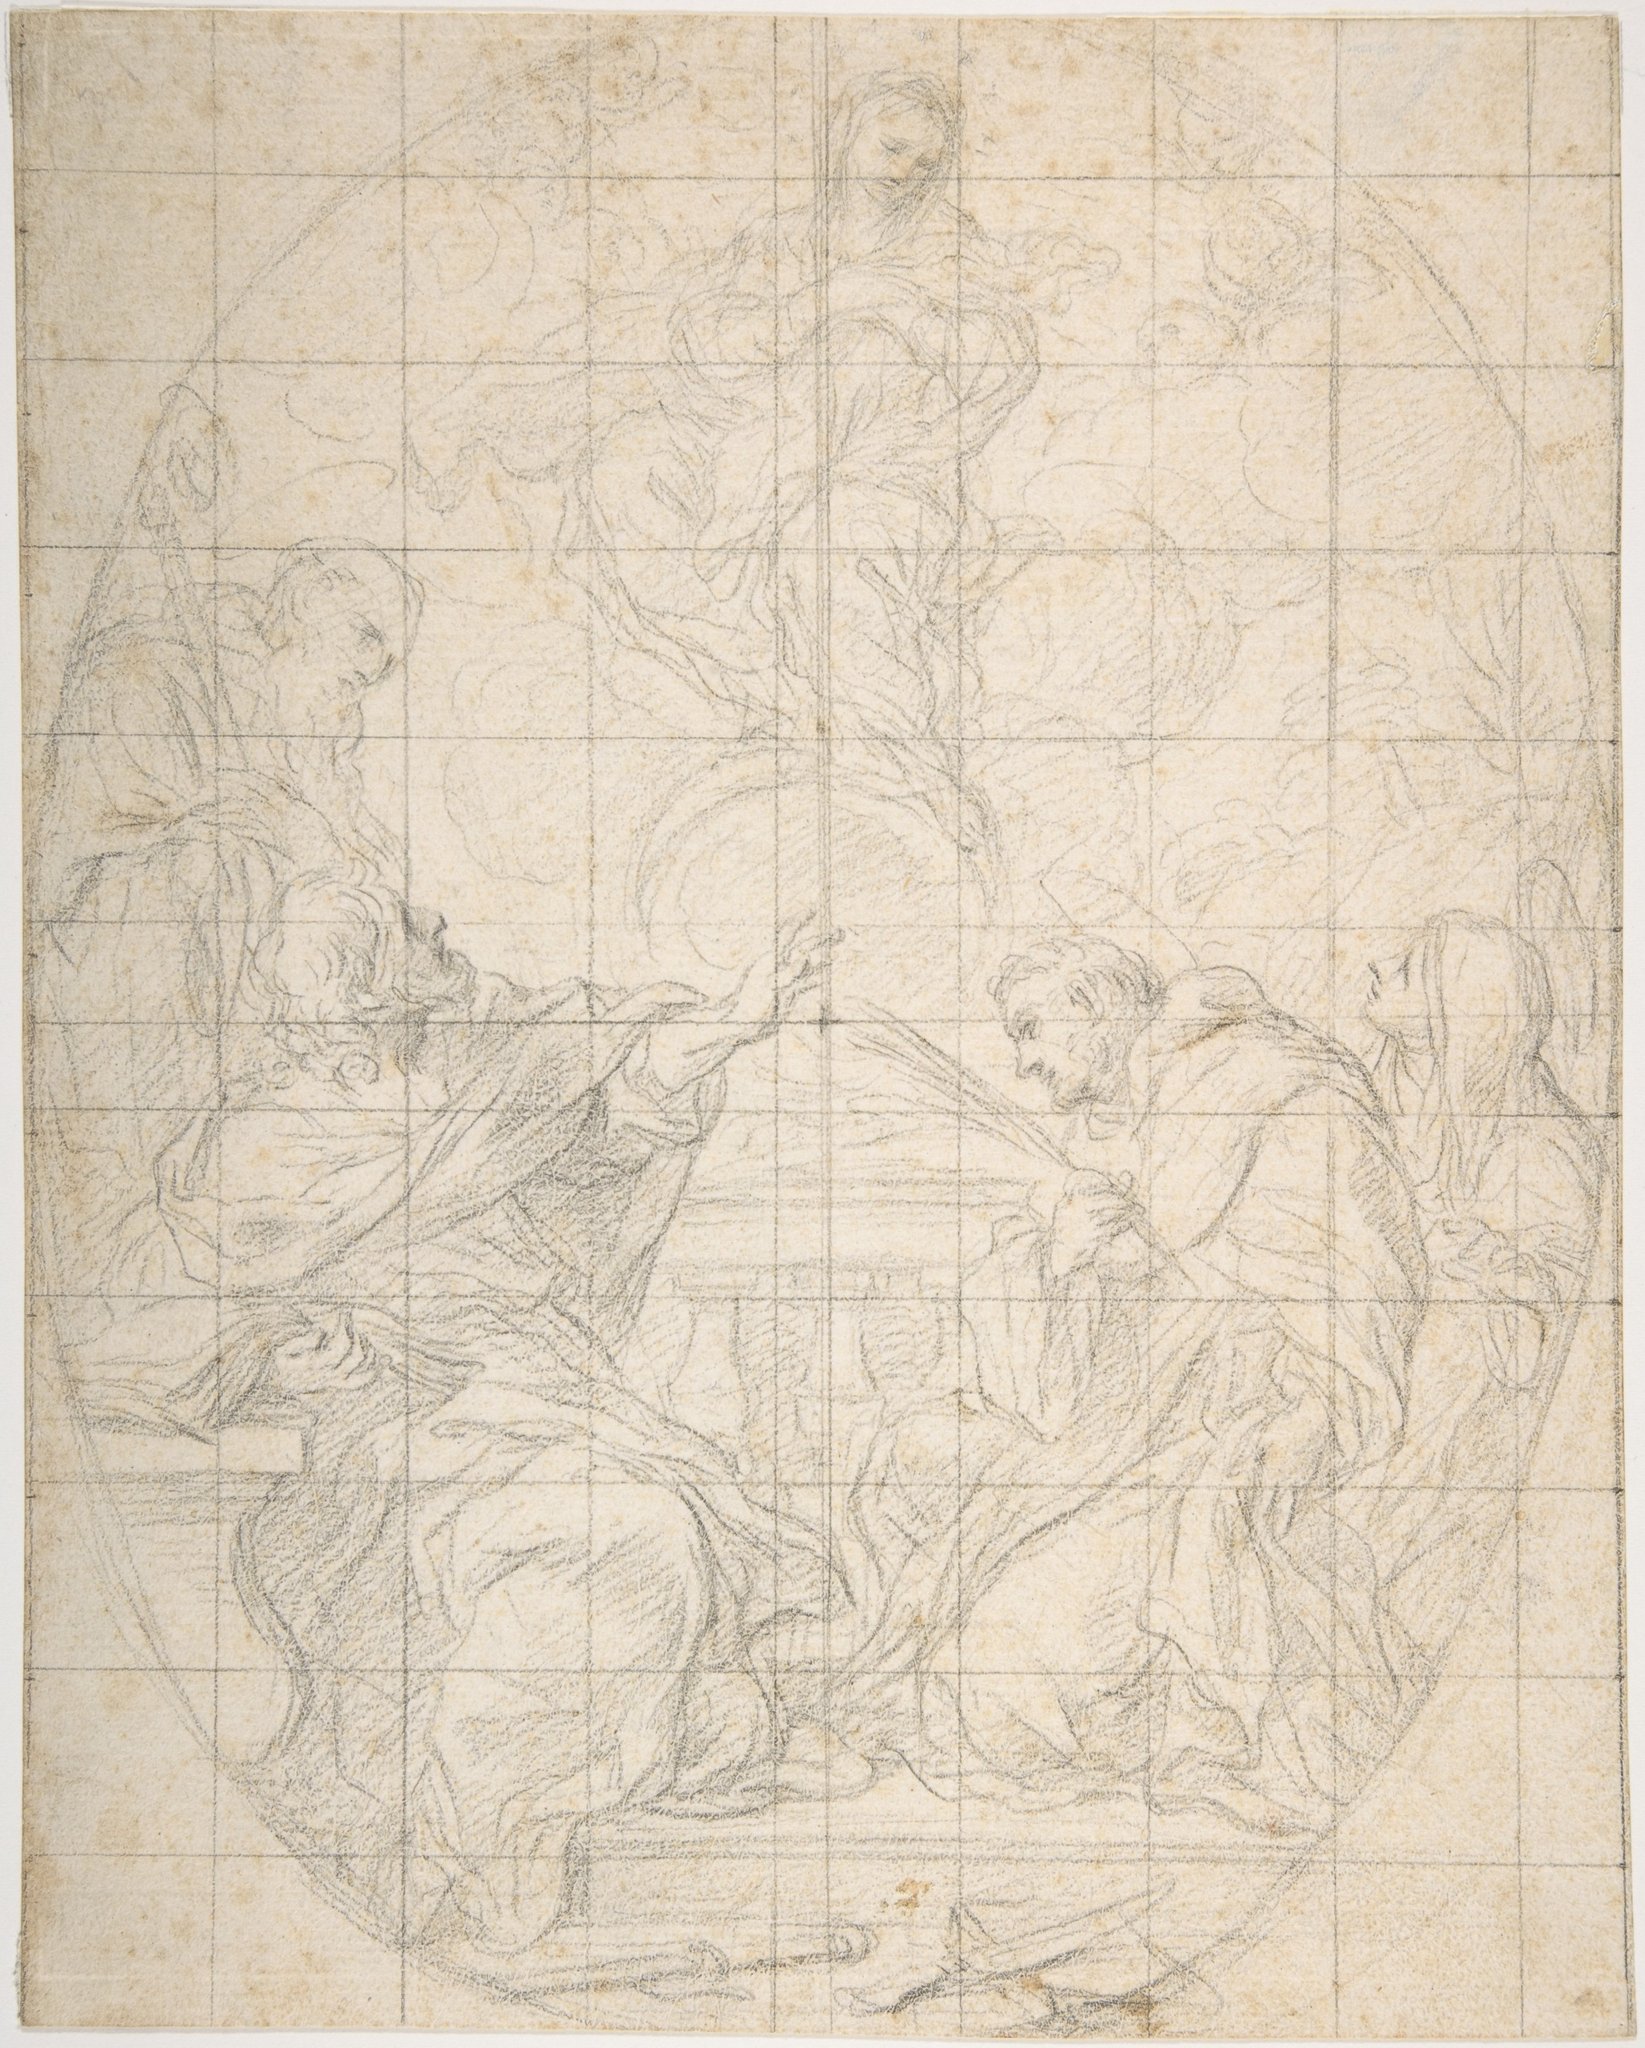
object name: drawing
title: The Virgin Immaculate Appearing to Four Saints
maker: ciro ferri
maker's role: artist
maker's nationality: italian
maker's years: 1634-1689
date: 1634-1689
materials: chalk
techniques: drawing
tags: mary magdalene,virgin mary,saints